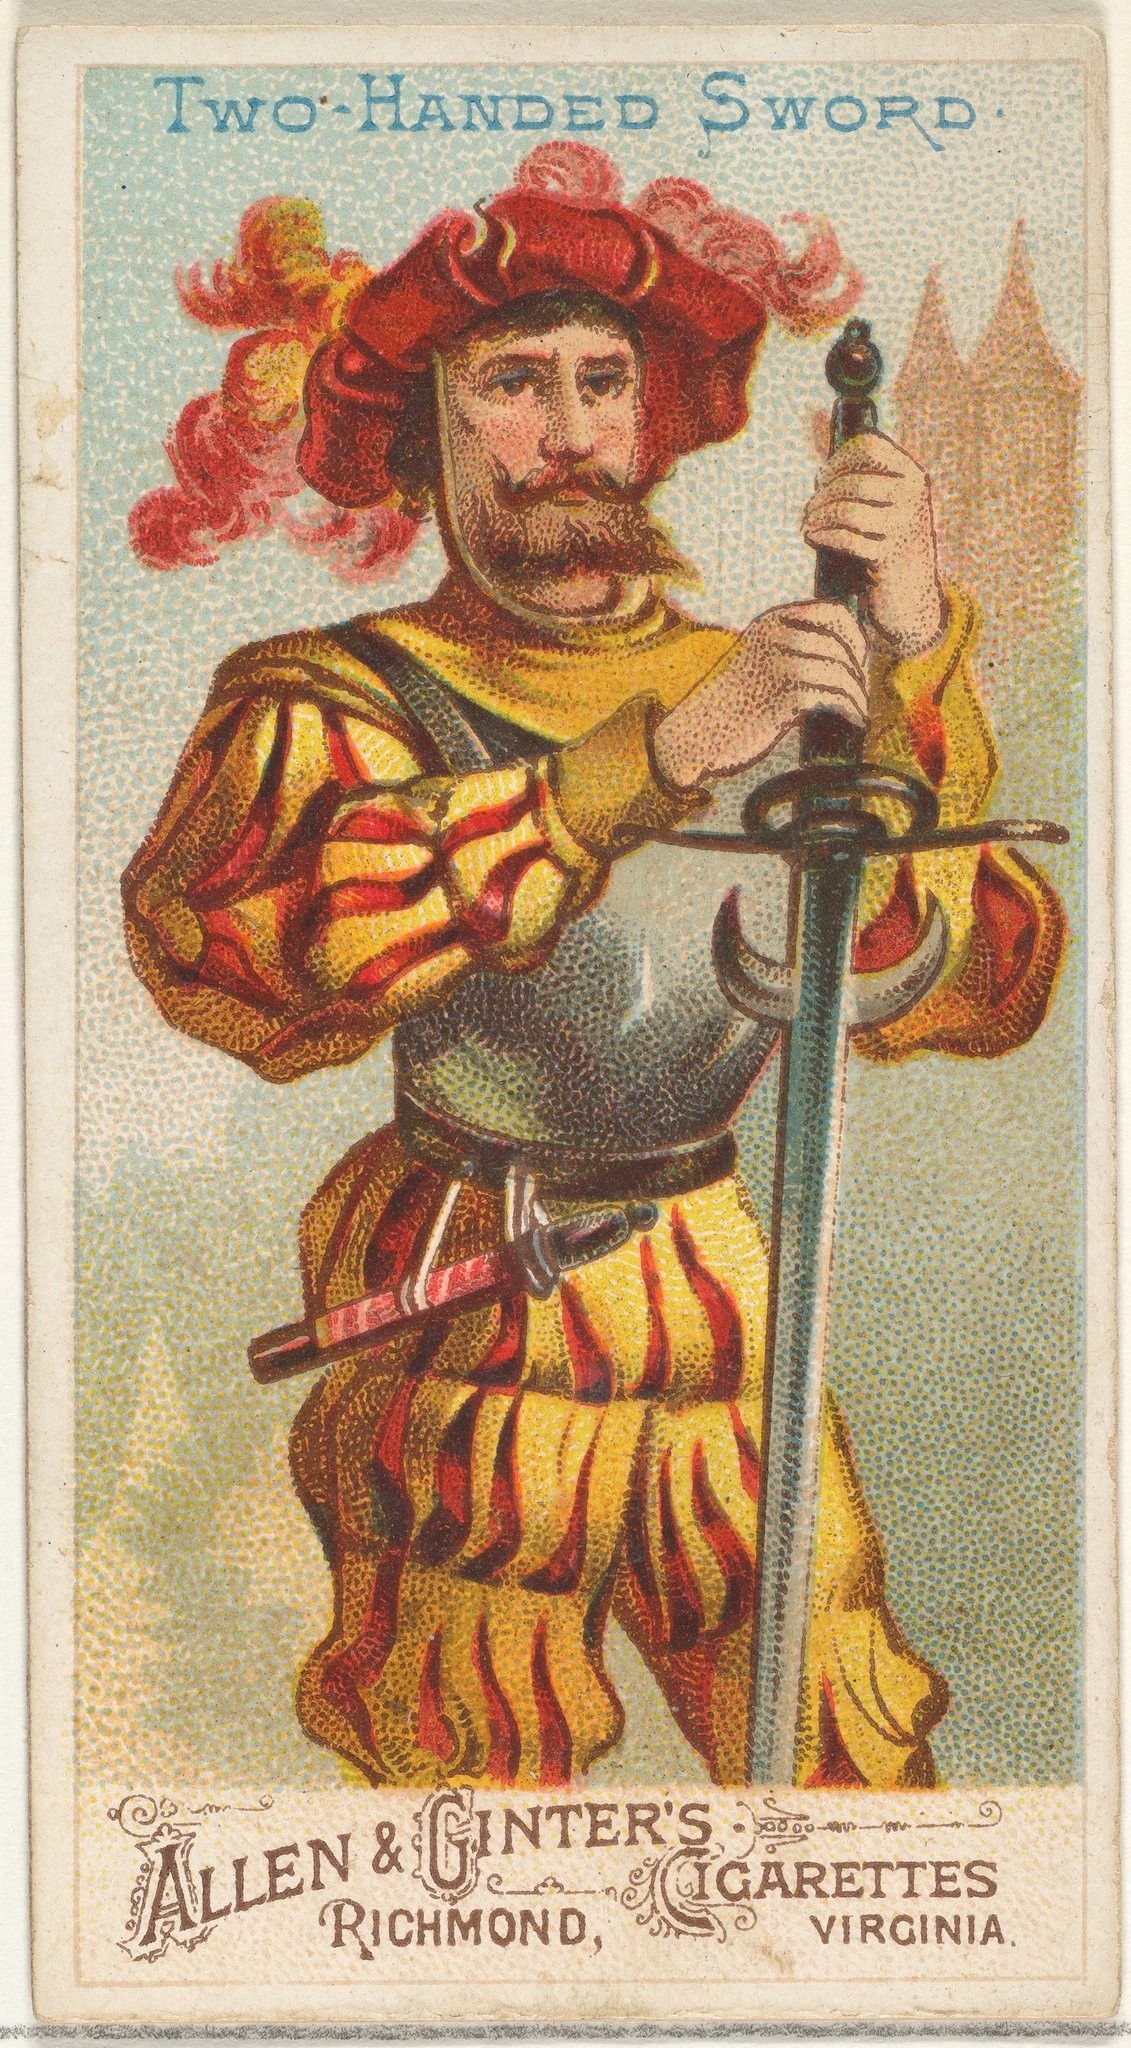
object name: print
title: Two-handed Sword, from the Arms of All Nations series (N3) for Allen & Ginter Cigarettes Brands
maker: allen & ginter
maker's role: publisher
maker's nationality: american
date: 1887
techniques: color lithograph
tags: swords,men